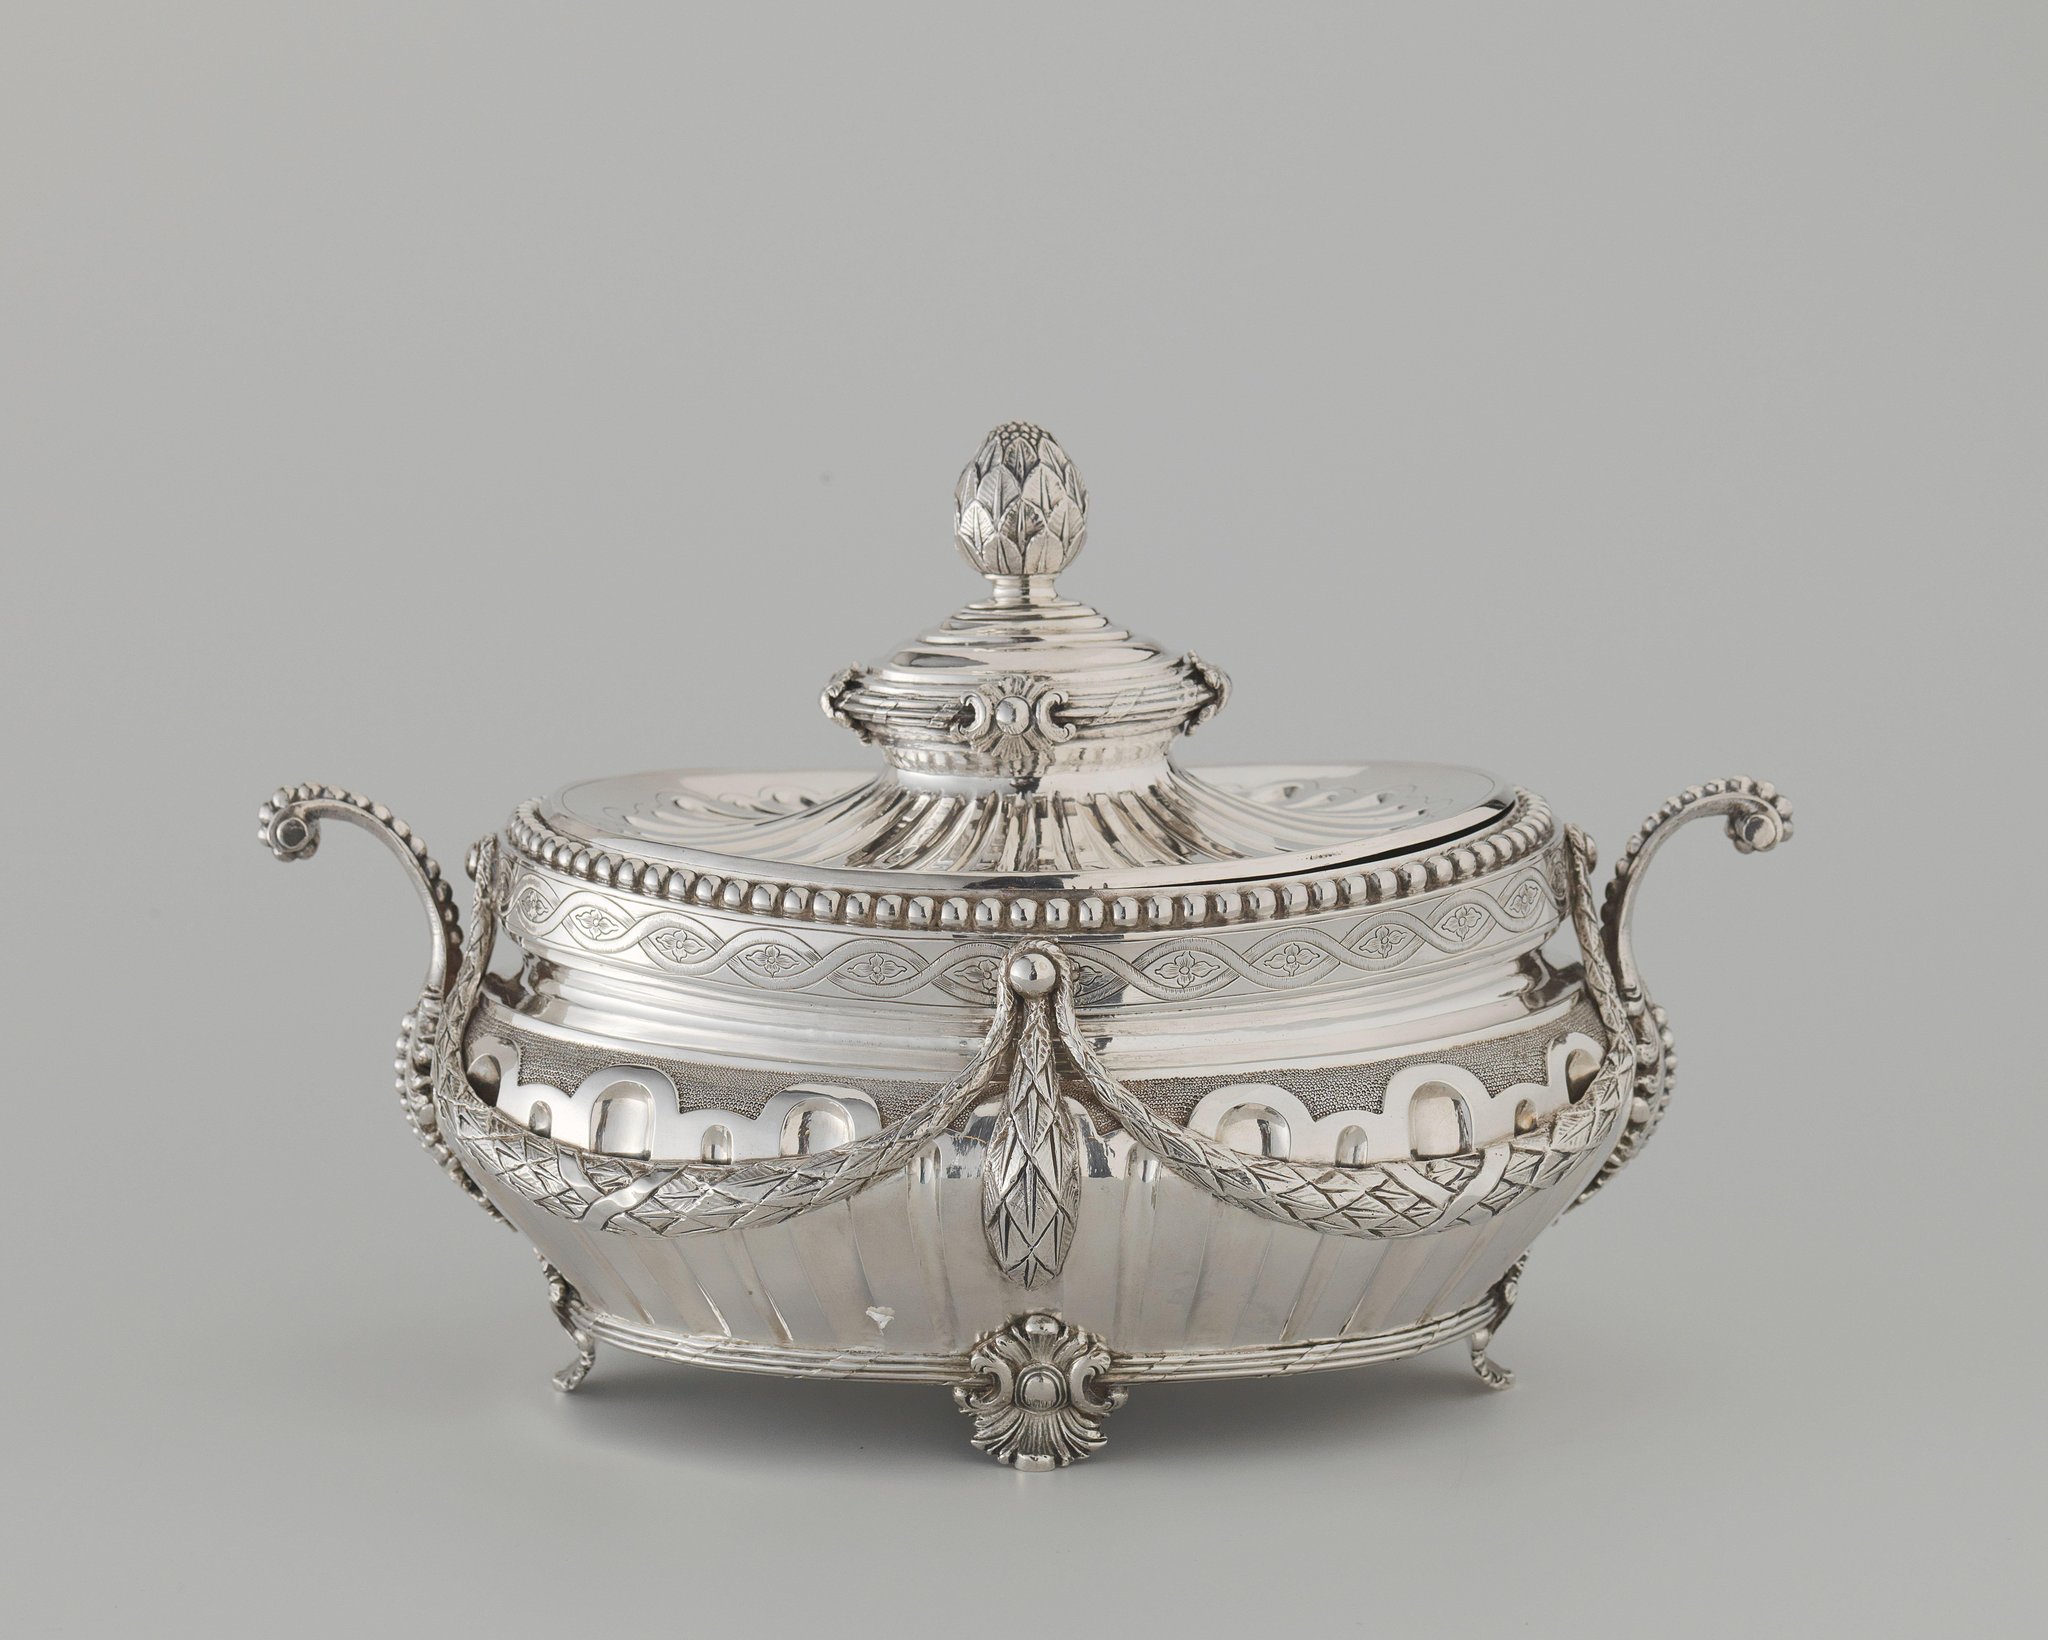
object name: binnenbak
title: Binnenbak ven een kleine (B en C) ovale terrine in Lodewijk XVI-stijl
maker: philippus priee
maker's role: silversmith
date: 1773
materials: silver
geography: middelburg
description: Binnenbak van een kleine (B en C) ovale terrine in Lodewijk XVI-stijl.